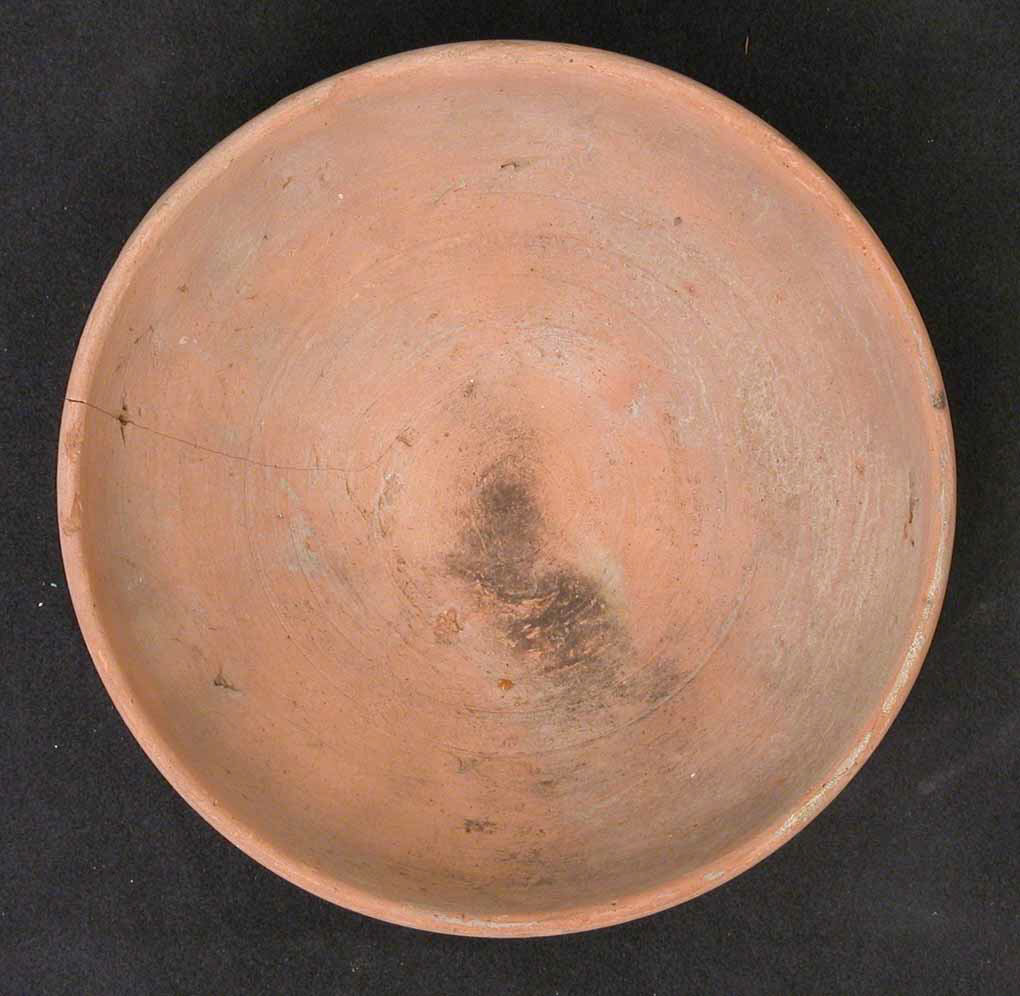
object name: bowl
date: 801-900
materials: earthenware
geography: iran